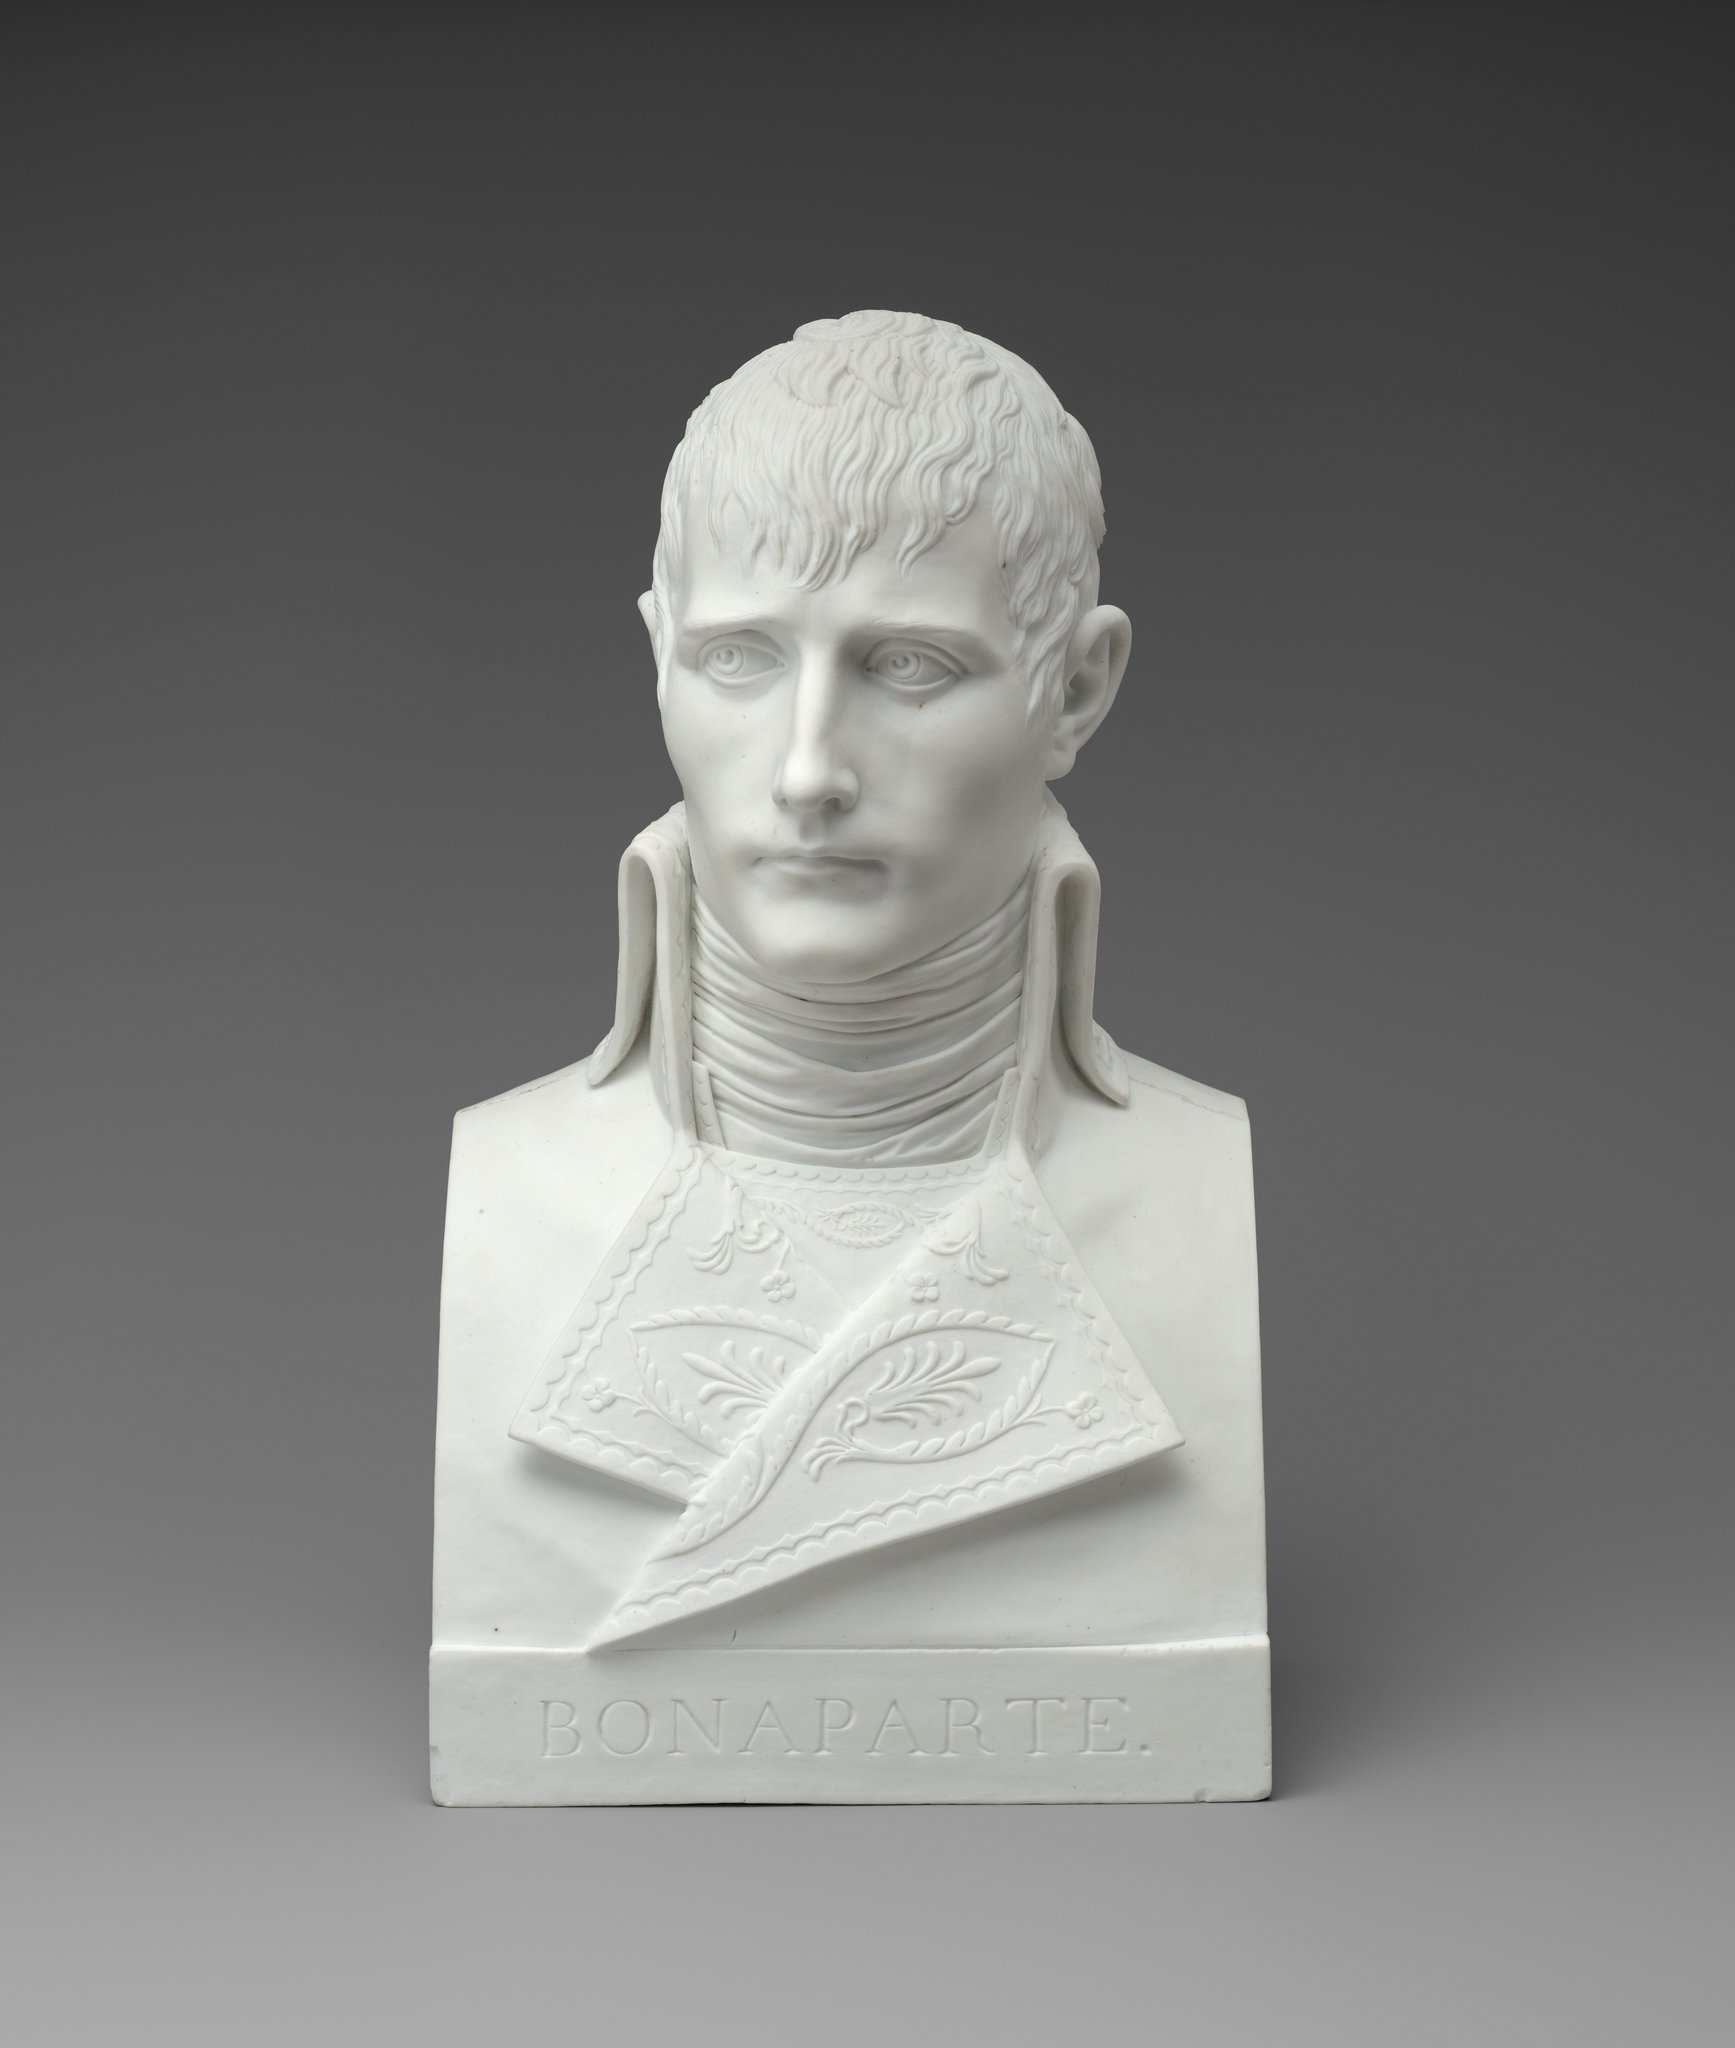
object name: bust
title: Napoleon Bonaparte (1769–1821) as First Consul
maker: dihl et guérhard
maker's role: factory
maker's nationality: french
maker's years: 1781-1824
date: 1800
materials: biscuit, paste, porcelain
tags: napoleon i,portraits